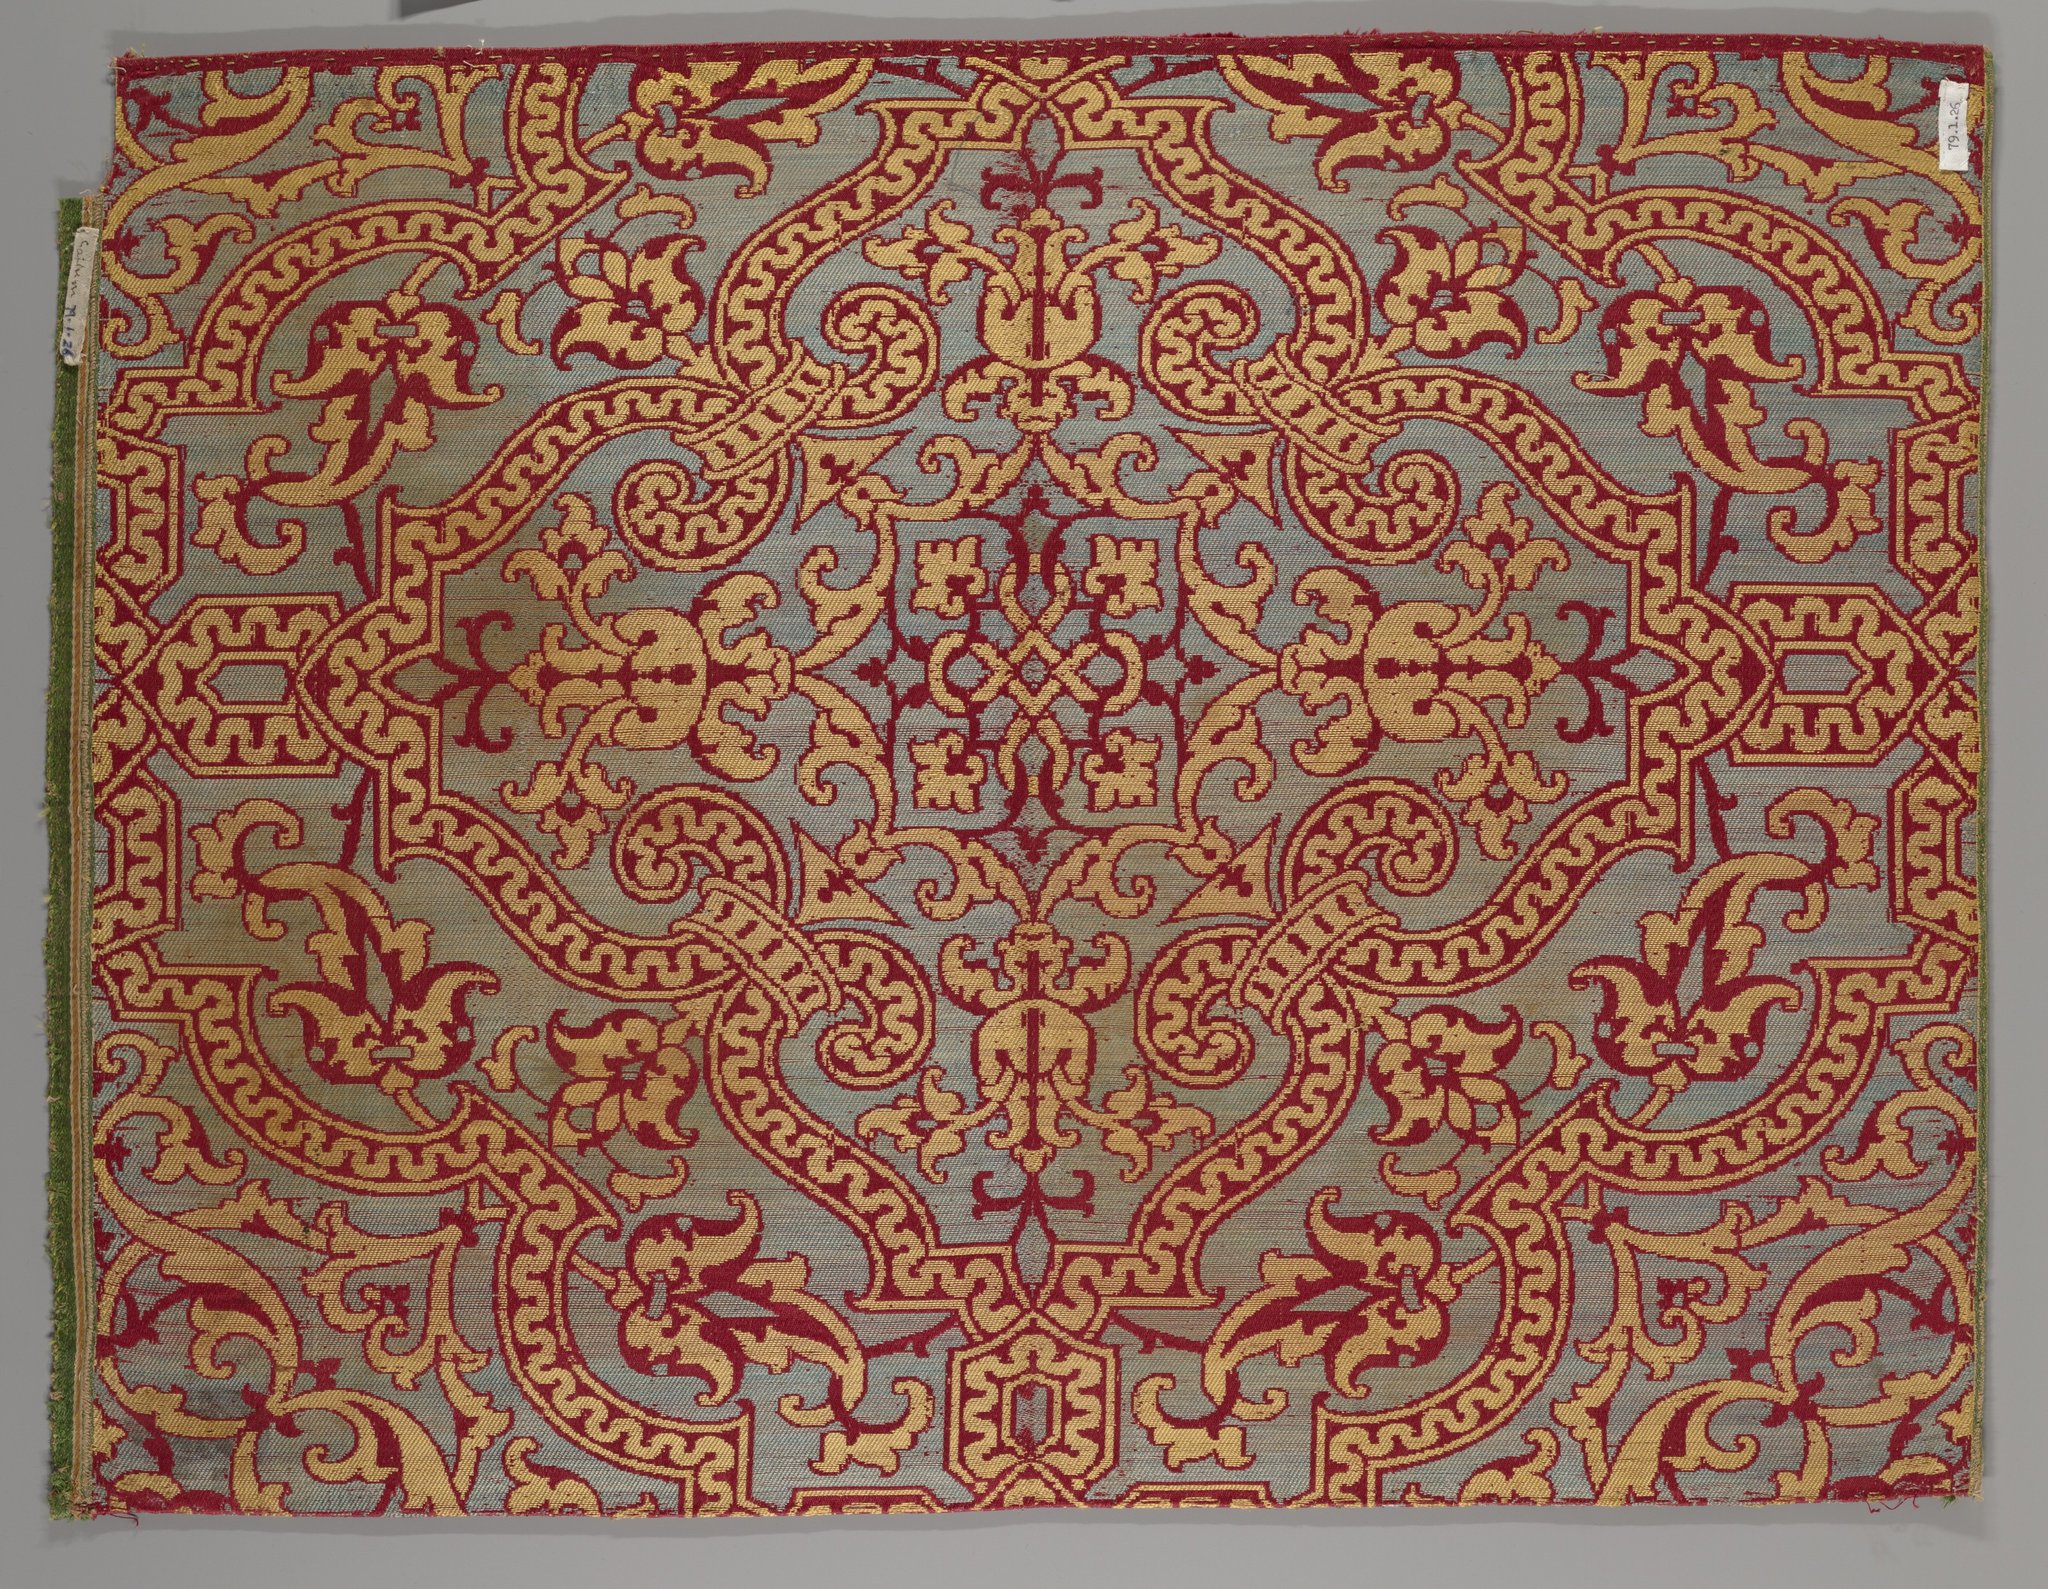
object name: piece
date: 1601-1700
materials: silk